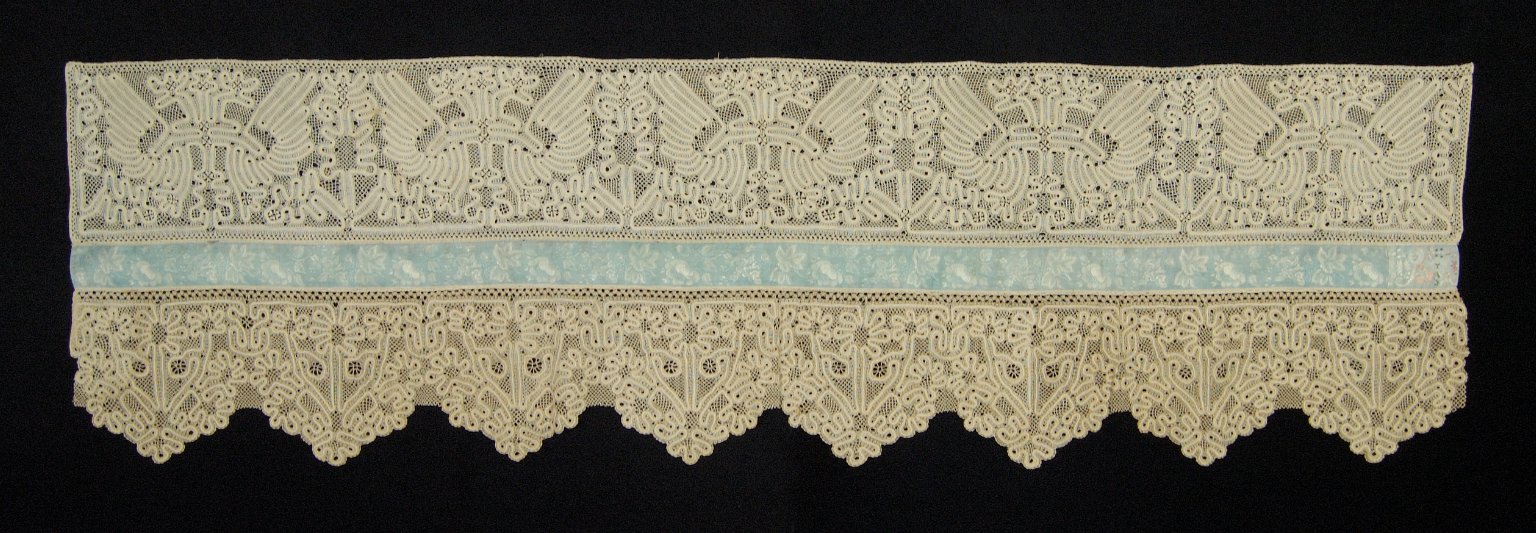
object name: border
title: Bed curtain border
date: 1800-1850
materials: linen, silk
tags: flowers